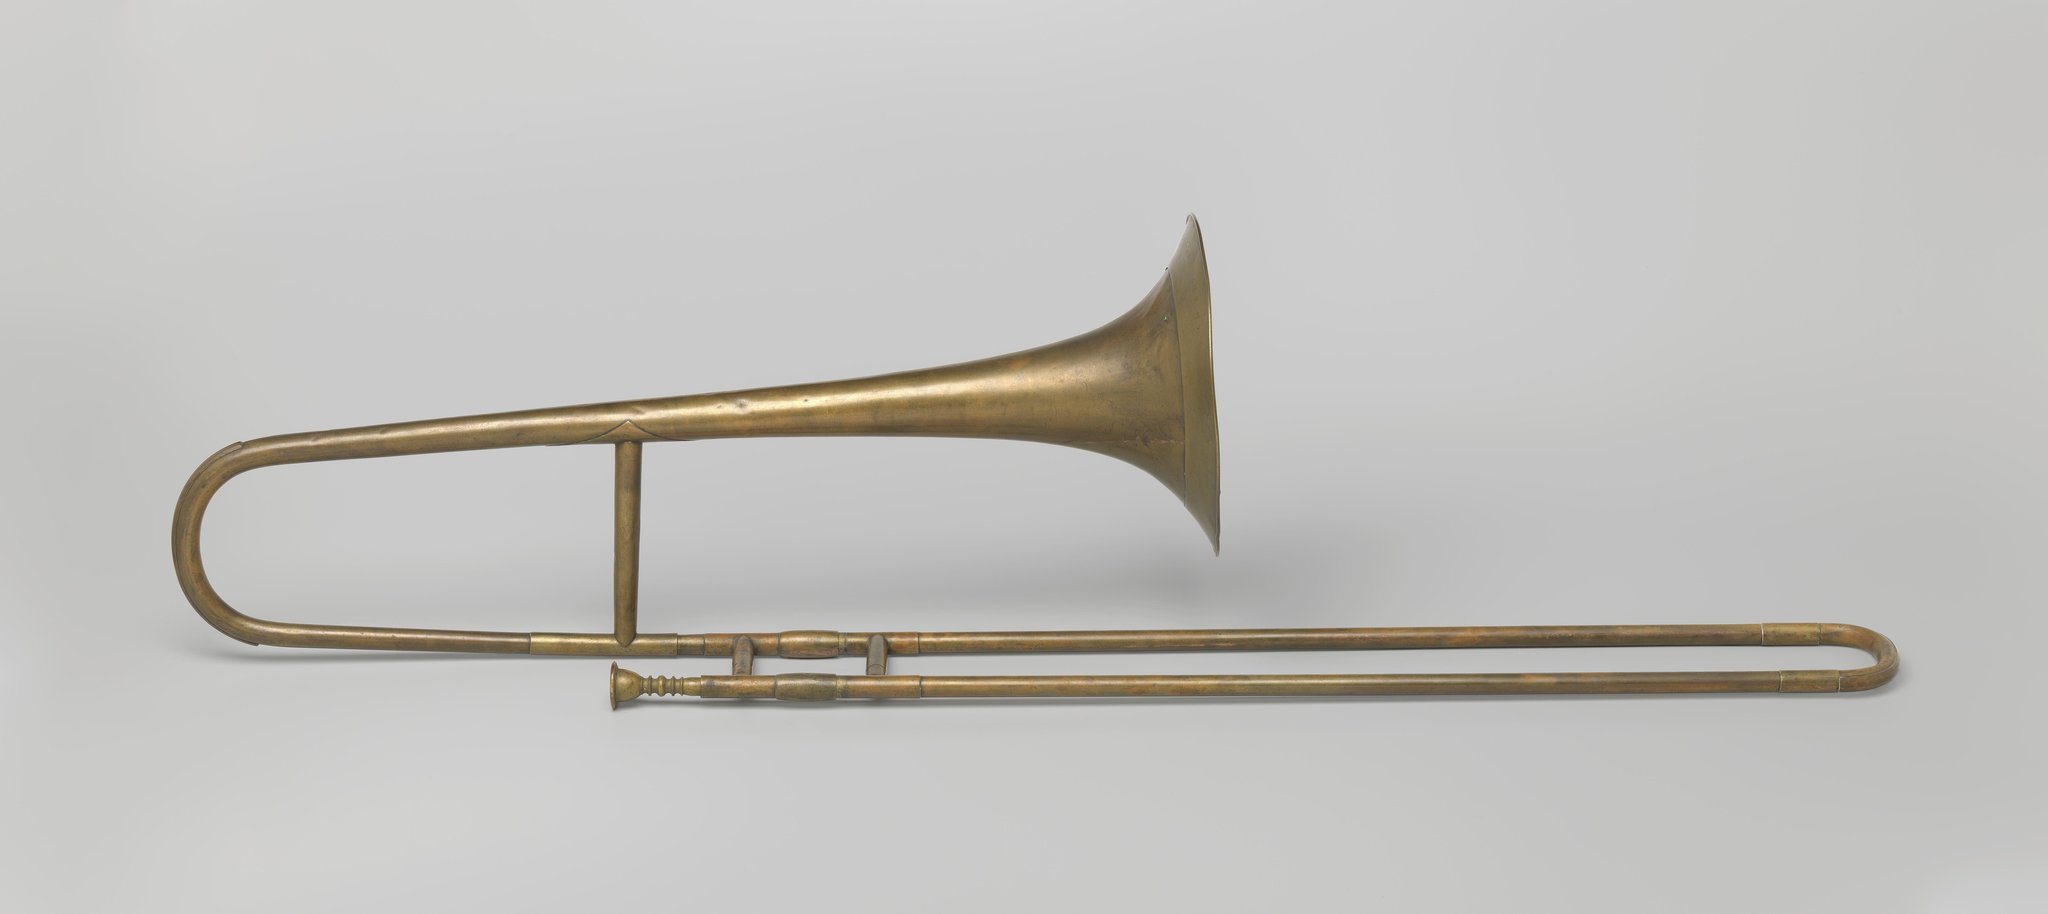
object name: musical instrument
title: Trombone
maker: christoffel rep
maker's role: musical instrument maker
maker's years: 1797-1872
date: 1850-1900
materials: brass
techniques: engraving, hammering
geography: amsterdam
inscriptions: name: ‘CH: REP. AMSTERDAM’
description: Trombone van messing, met de naam van de maker geggraveerd rond de beker: CH: REP. AMSTERDAM. Het geheel bestaat uit een schuifgedeelte, een bekerstuk en een mondstuk. Stemming: bes.